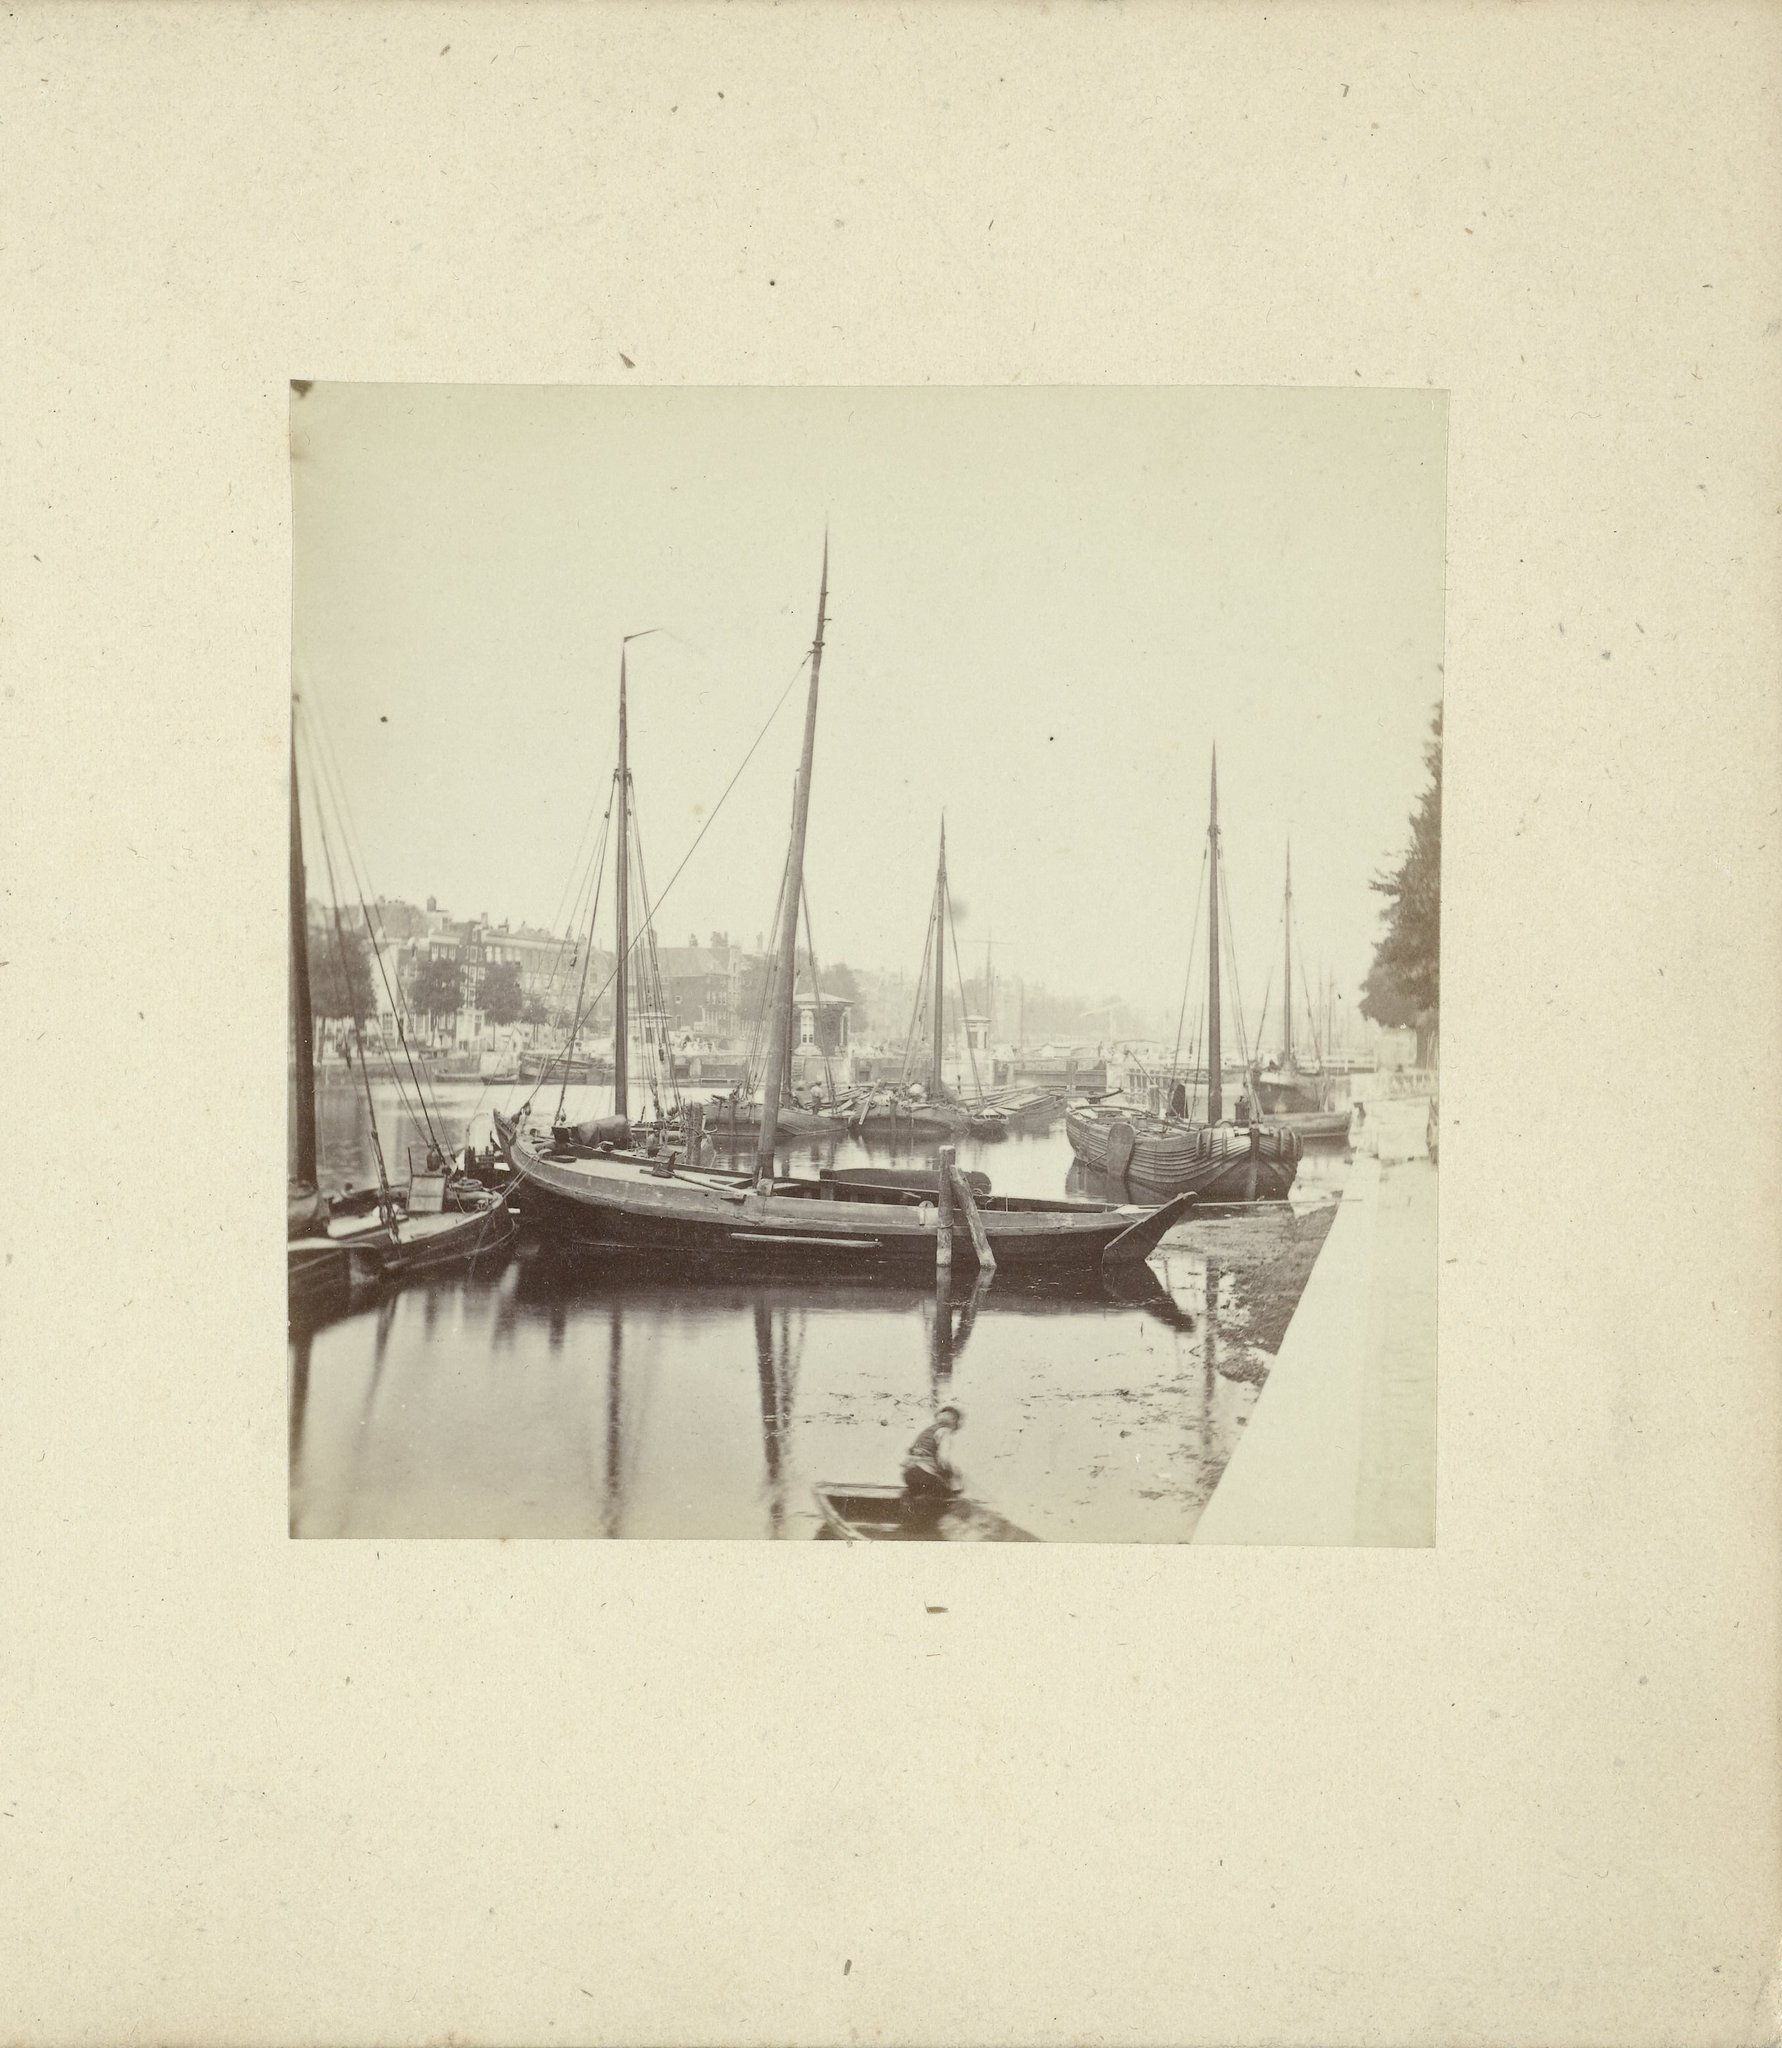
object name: photograph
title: De Binnenamstel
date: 1860-1875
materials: cardboard, paper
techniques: albumen print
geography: amsterdam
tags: ships (in general) - cc - more than one ship